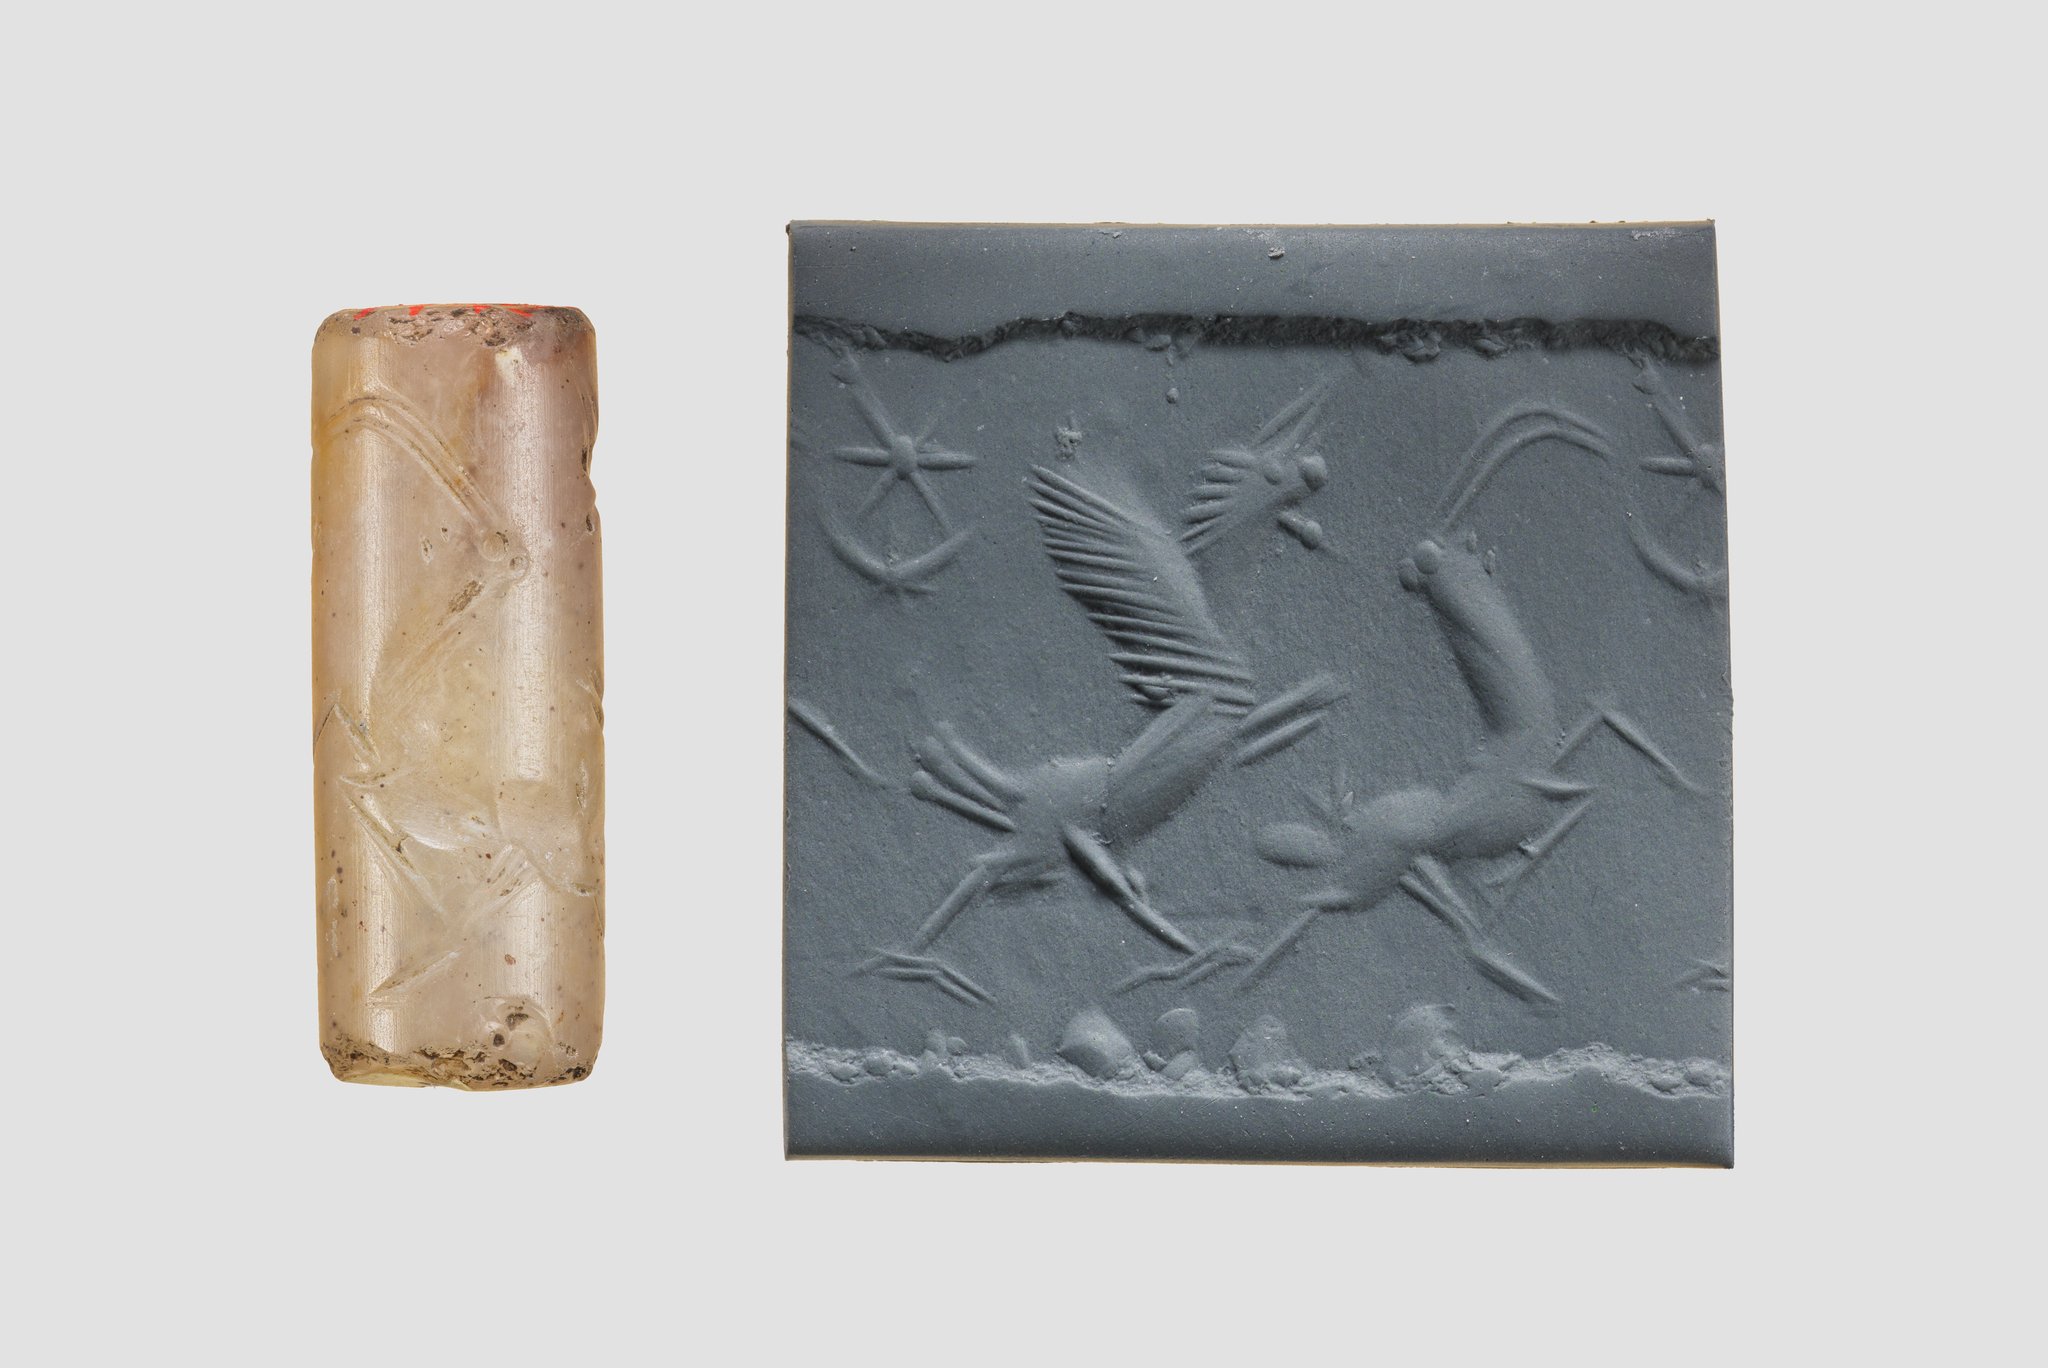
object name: cylinder seal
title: Cylinder seal with animal-monster contest scene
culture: babylonian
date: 900-701 BCE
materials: stone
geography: mesopotamia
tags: griffins,lions